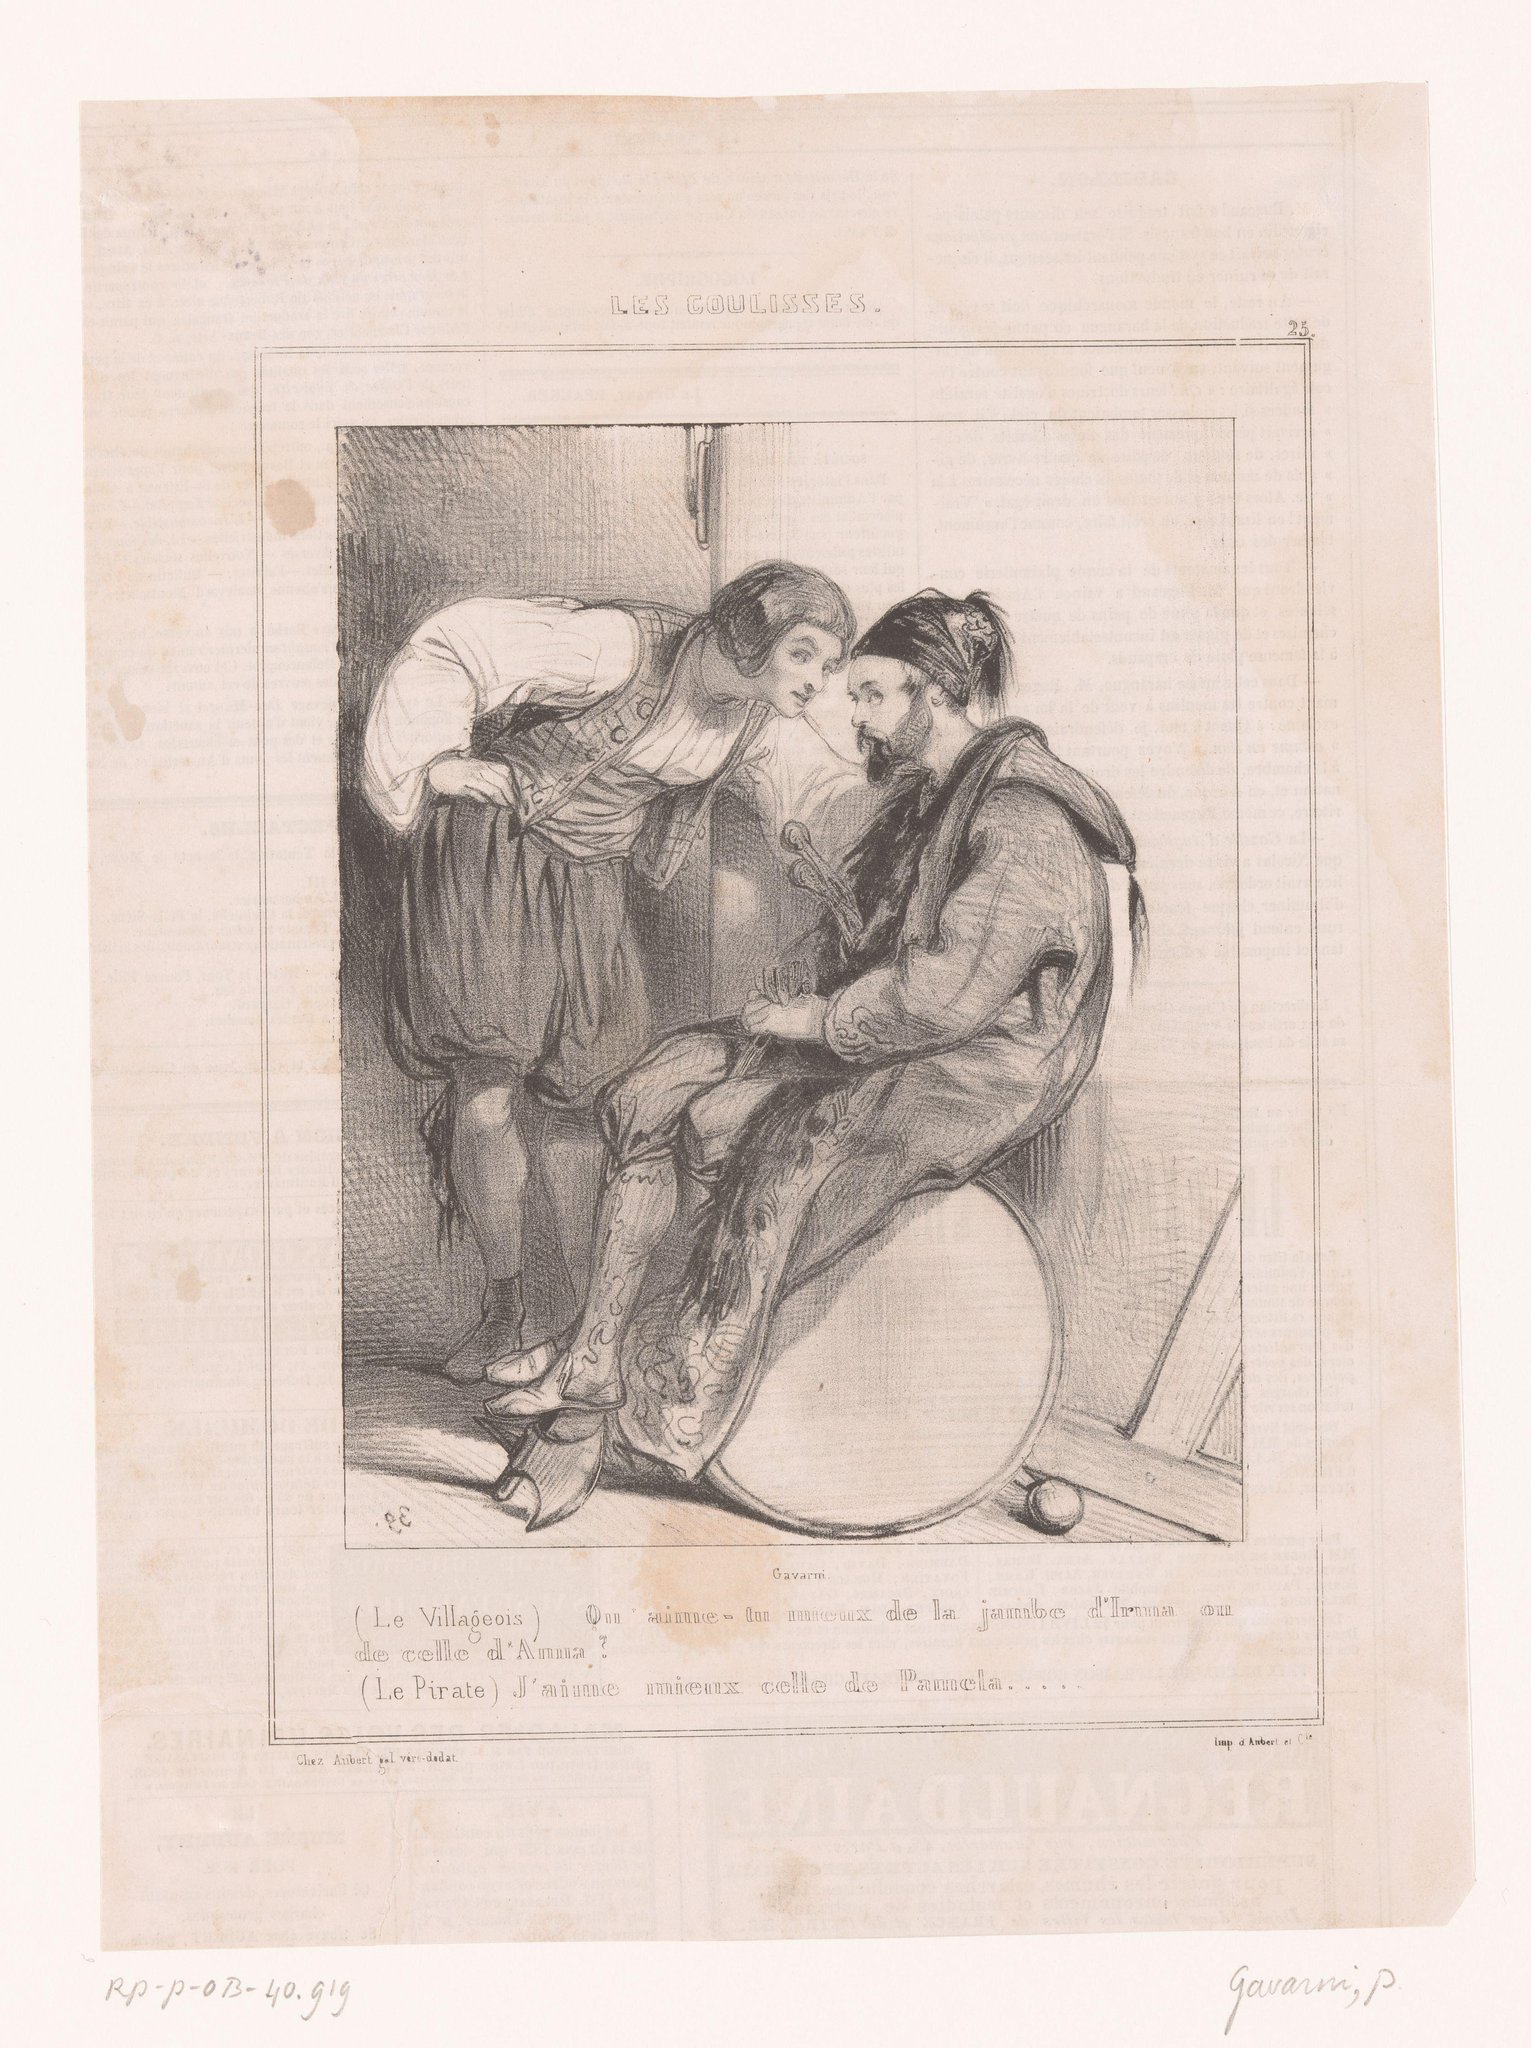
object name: cartoon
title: Twee acteurs praten met elkaar in de coulissen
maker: paul gavarni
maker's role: draughtsman, print maker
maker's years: 1804-1866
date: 1838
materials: paper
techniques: lithograph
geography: paris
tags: stage costume, behind the stage, actor, actress (non-work situations)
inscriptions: collector's mark: Lugt 2228a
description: De acteurs bespreken de benen van hun vrouwelijke collega's.